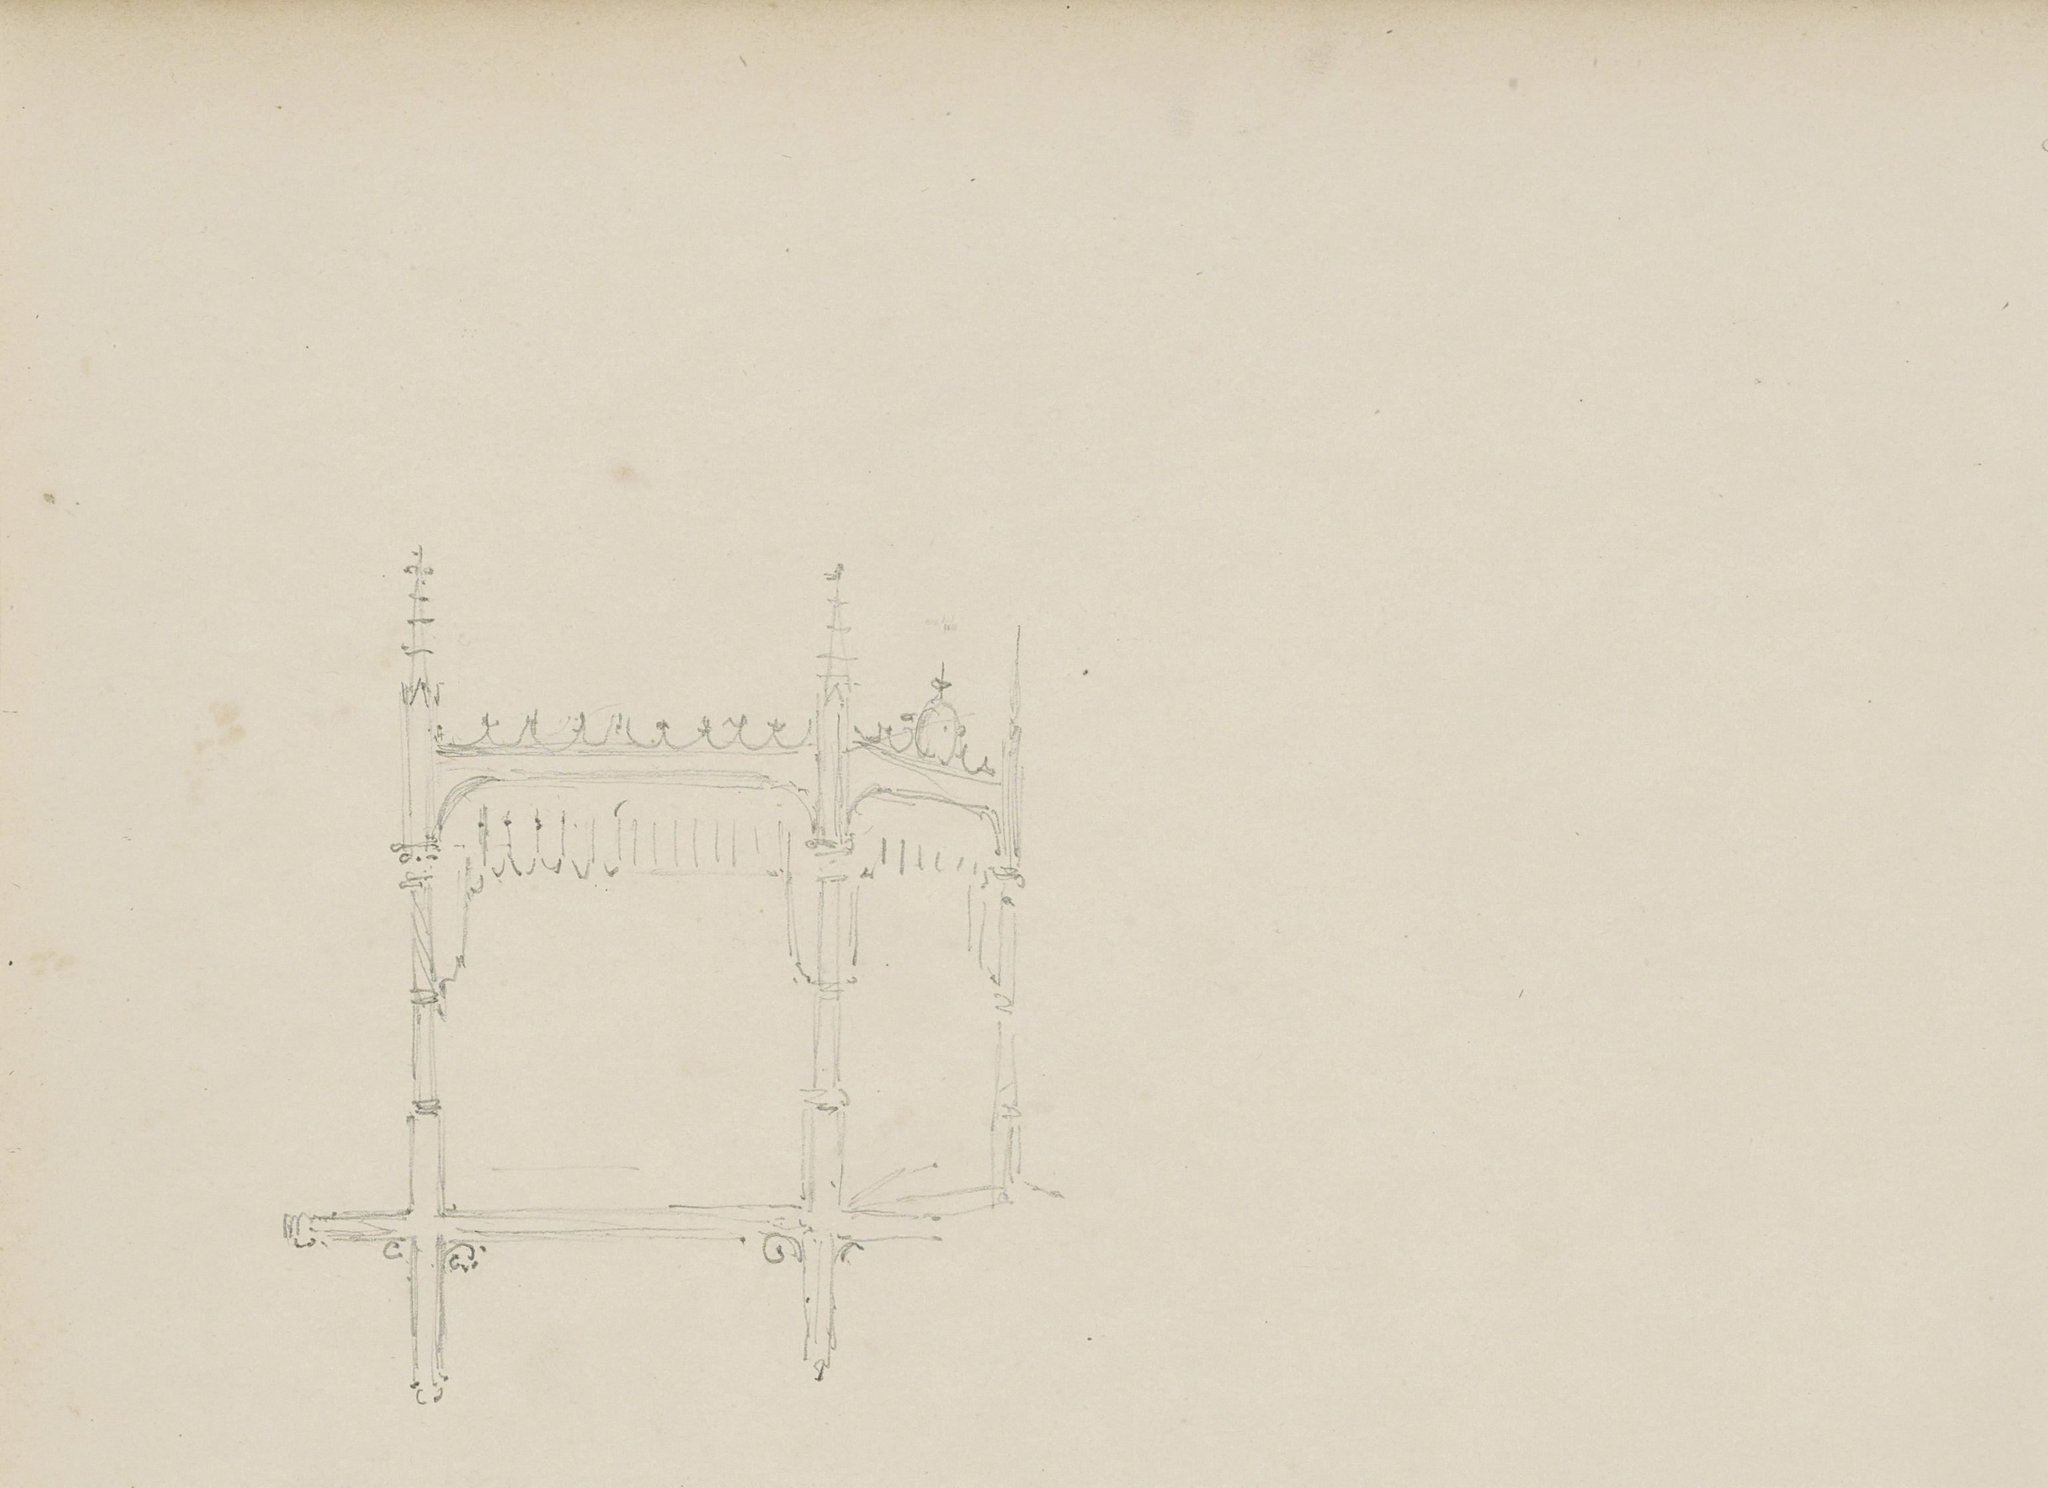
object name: sketchbook leaf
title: Baldakijn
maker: pierre joseph hubert cuypers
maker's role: draughtsman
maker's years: 1827-1921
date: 1857-1859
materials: paper, pencil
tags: canopy, baldachin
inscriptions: annotation: ‘Dais -/ [...]. 189’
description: Blad 9 recto uit een schetsboek met 77 bladen.